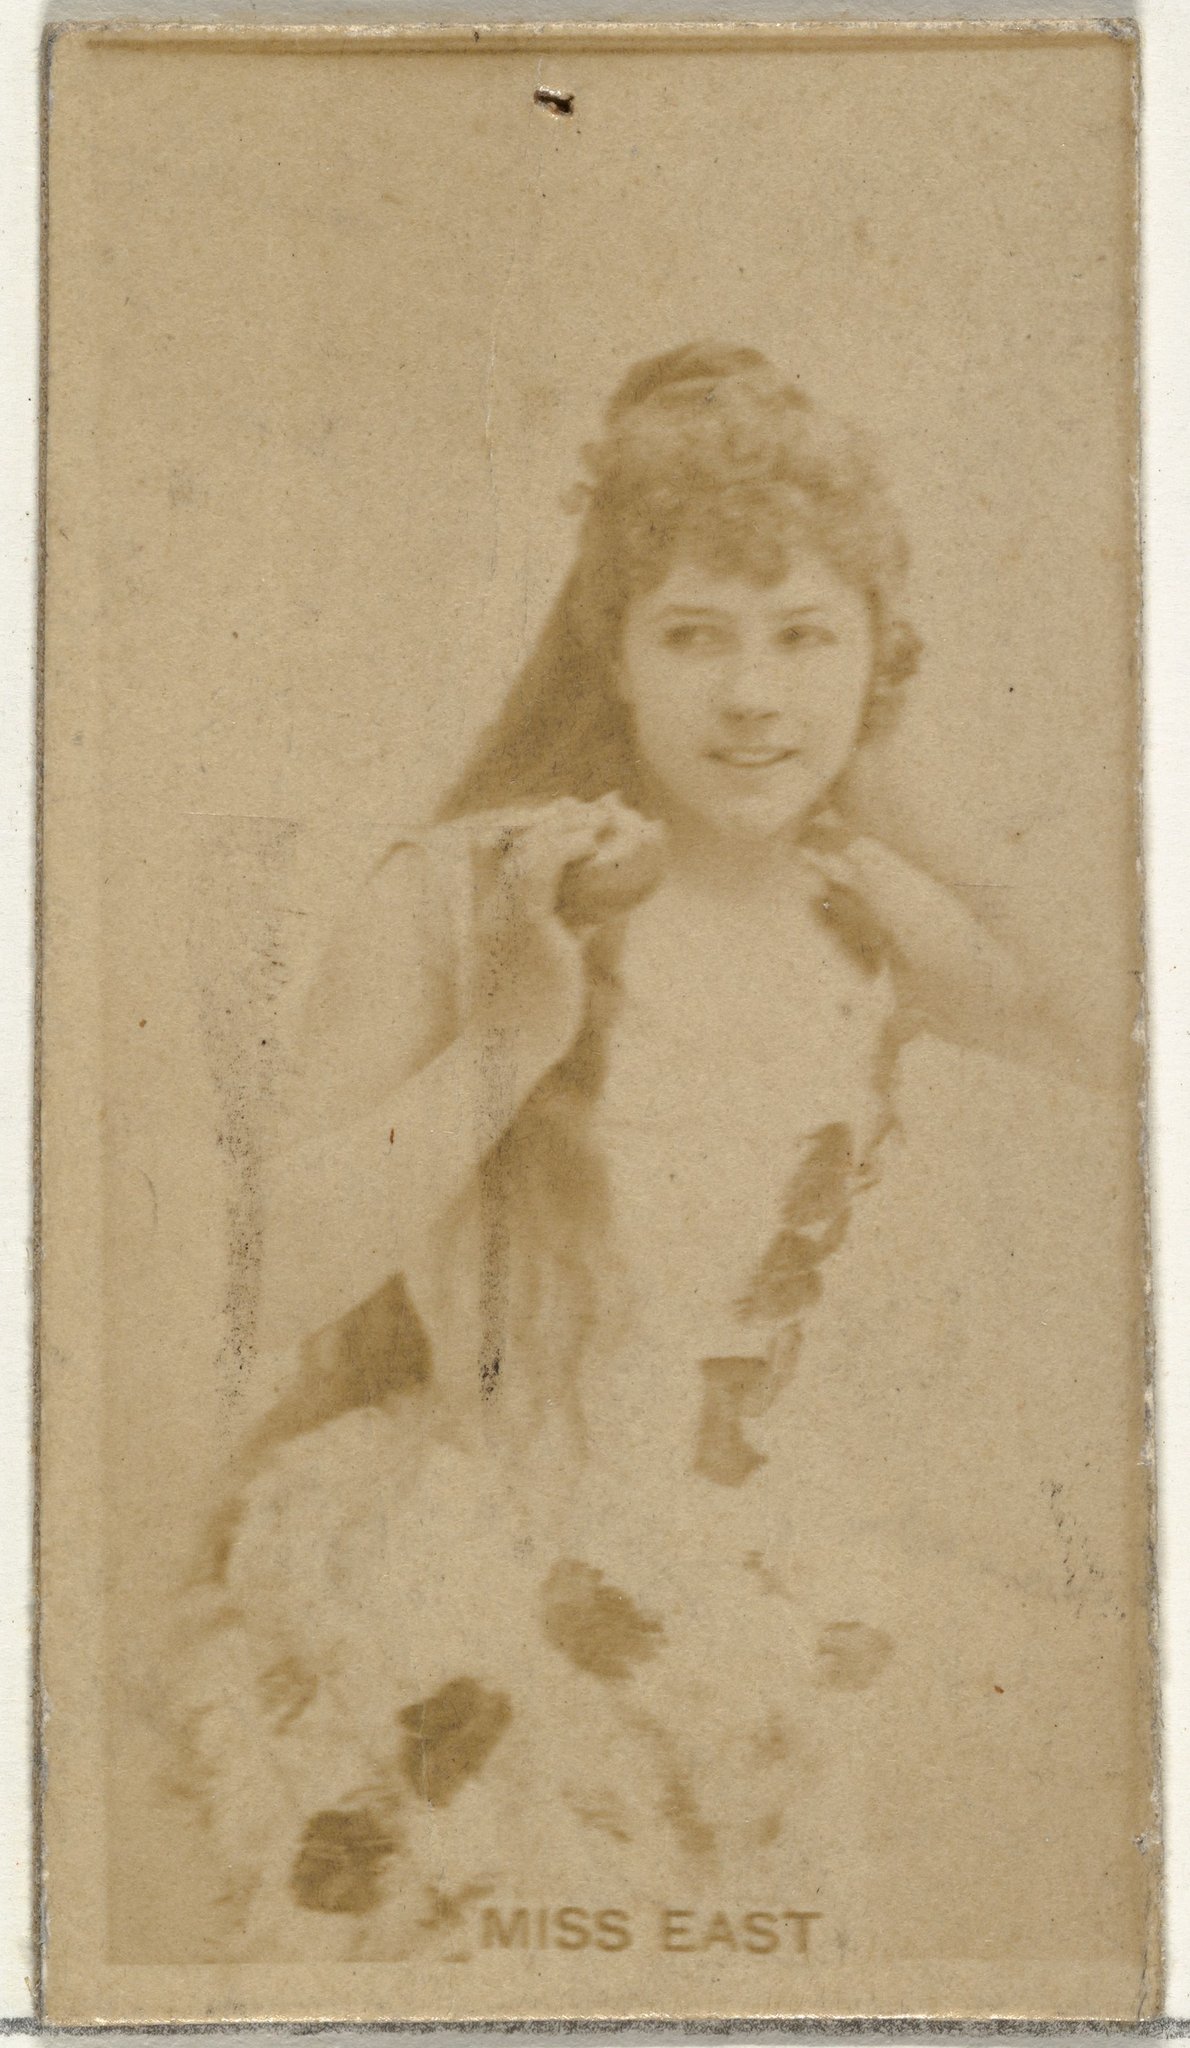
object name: photograph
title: Miss East, from the Actors and Actresses series (N145-8) issued by Duke Sons & Co. to promote Duke Cigarettes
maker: w. duke, sons & co.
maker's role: publisher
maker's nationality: american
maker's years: 1870-1920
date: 1891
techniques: albumen silver print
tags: portraits,women,actresses